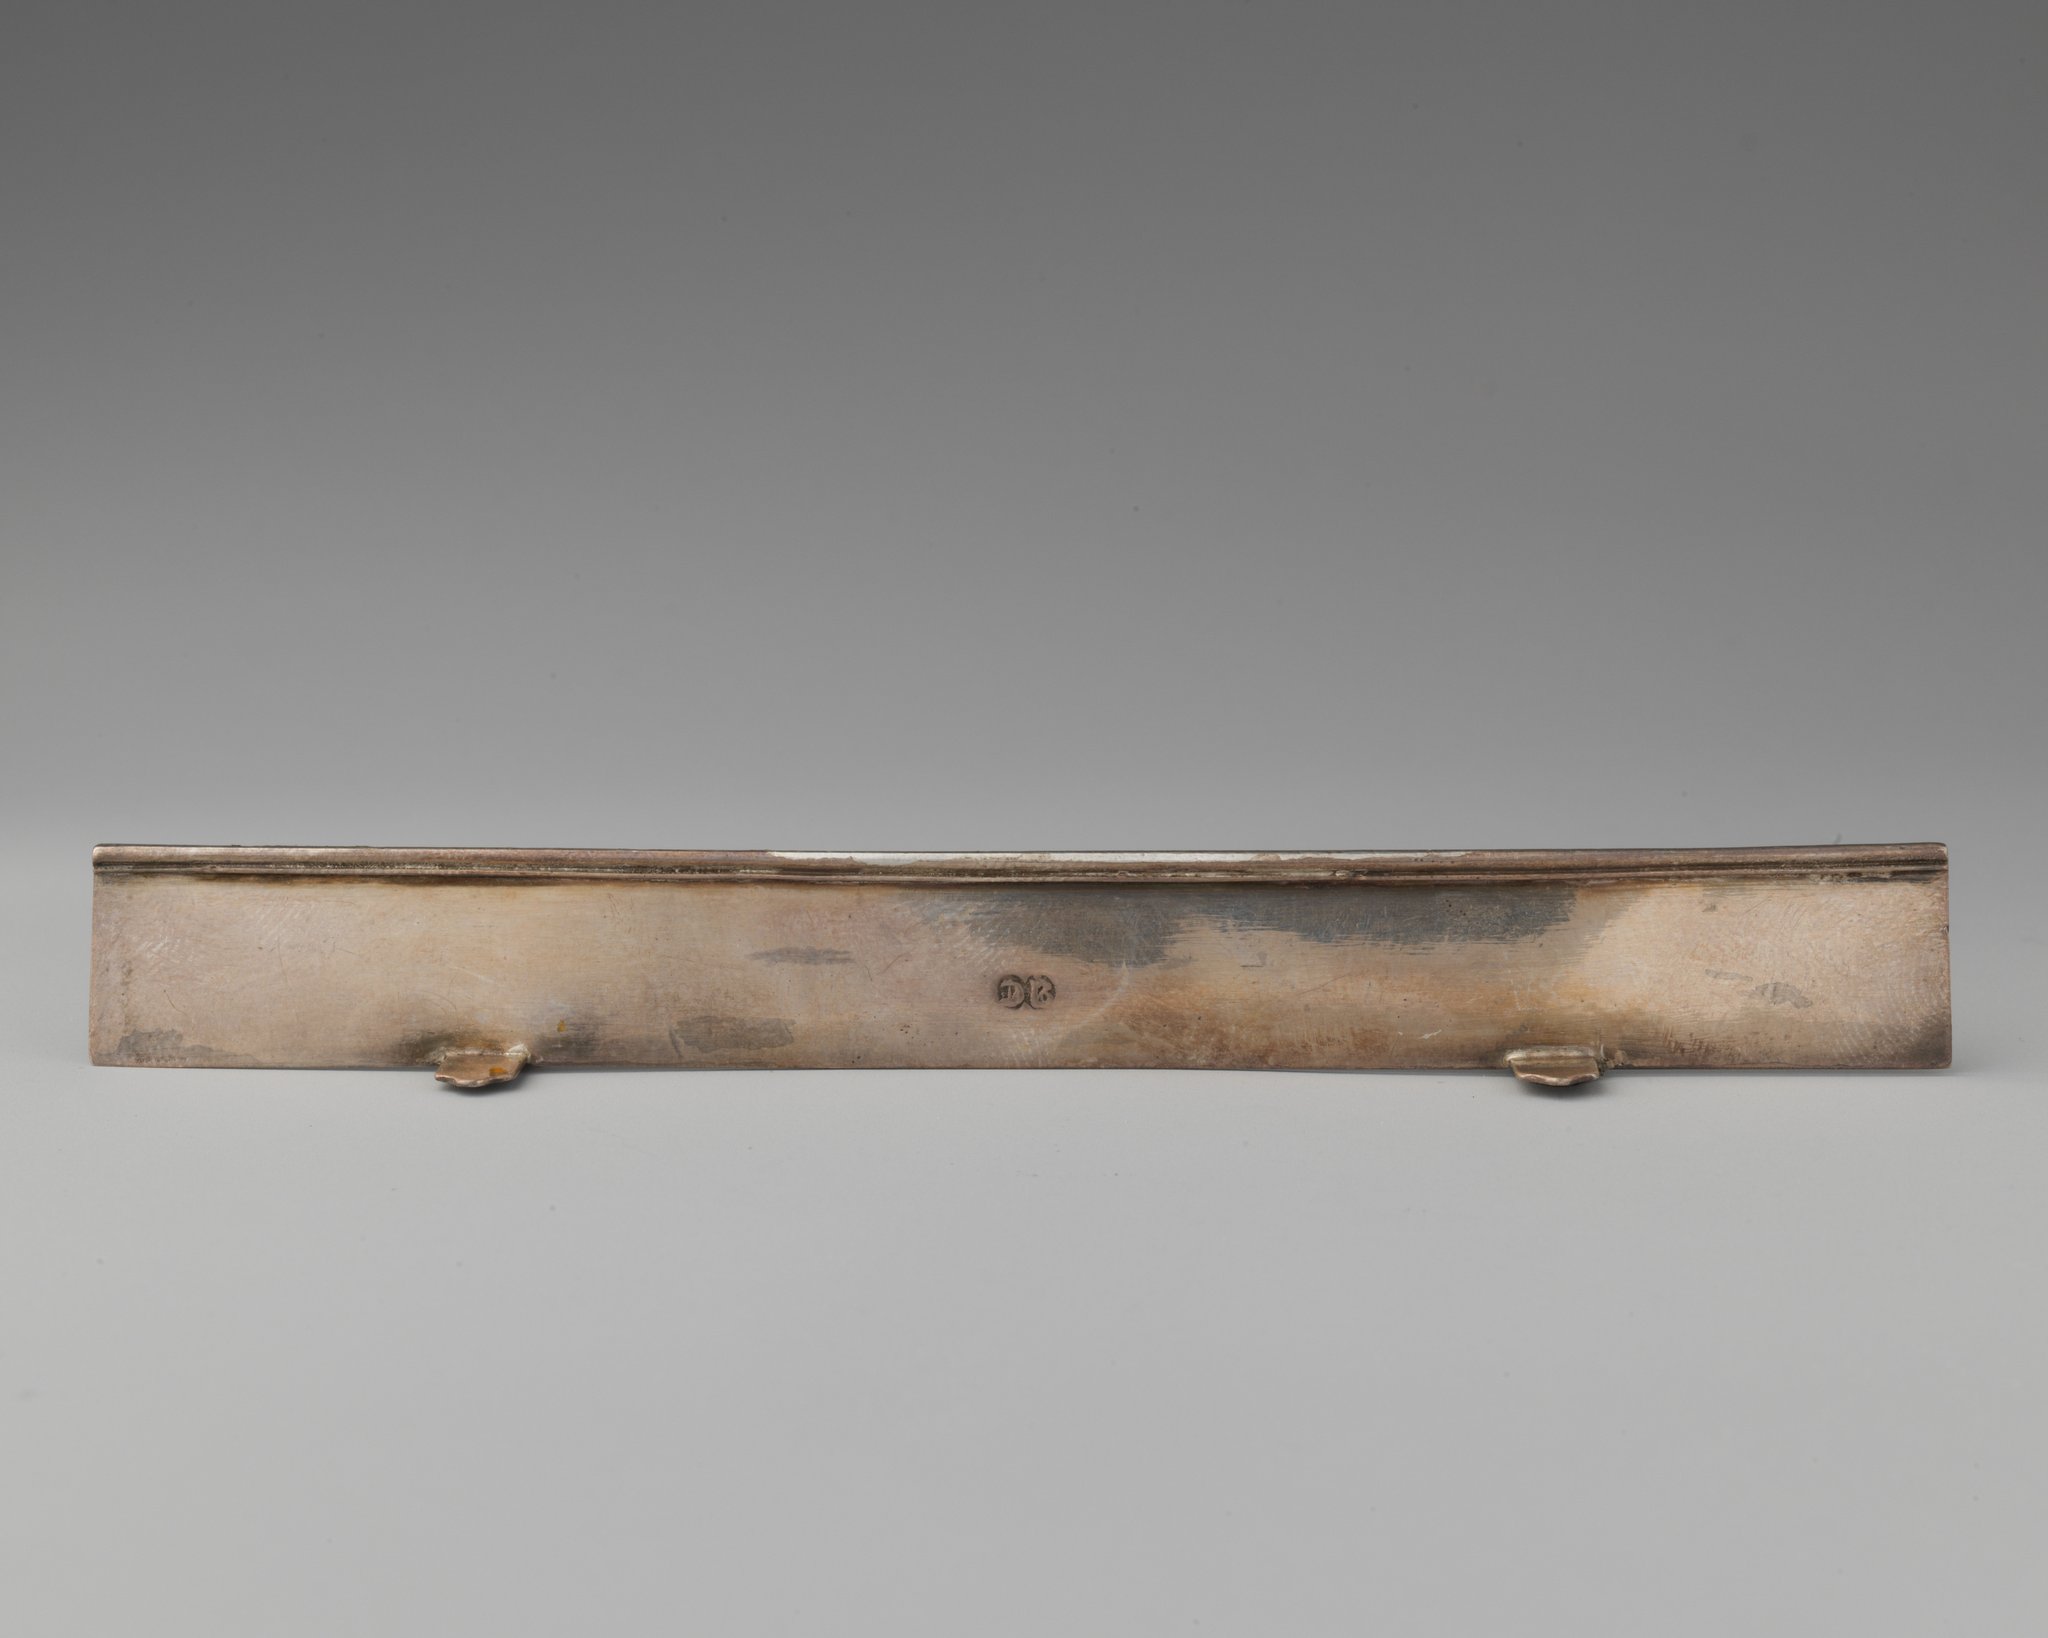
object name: fender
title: Miniature fender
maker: david clayton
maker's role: maker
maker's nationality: british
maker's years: 1659-1719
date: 1720-1730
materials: silver